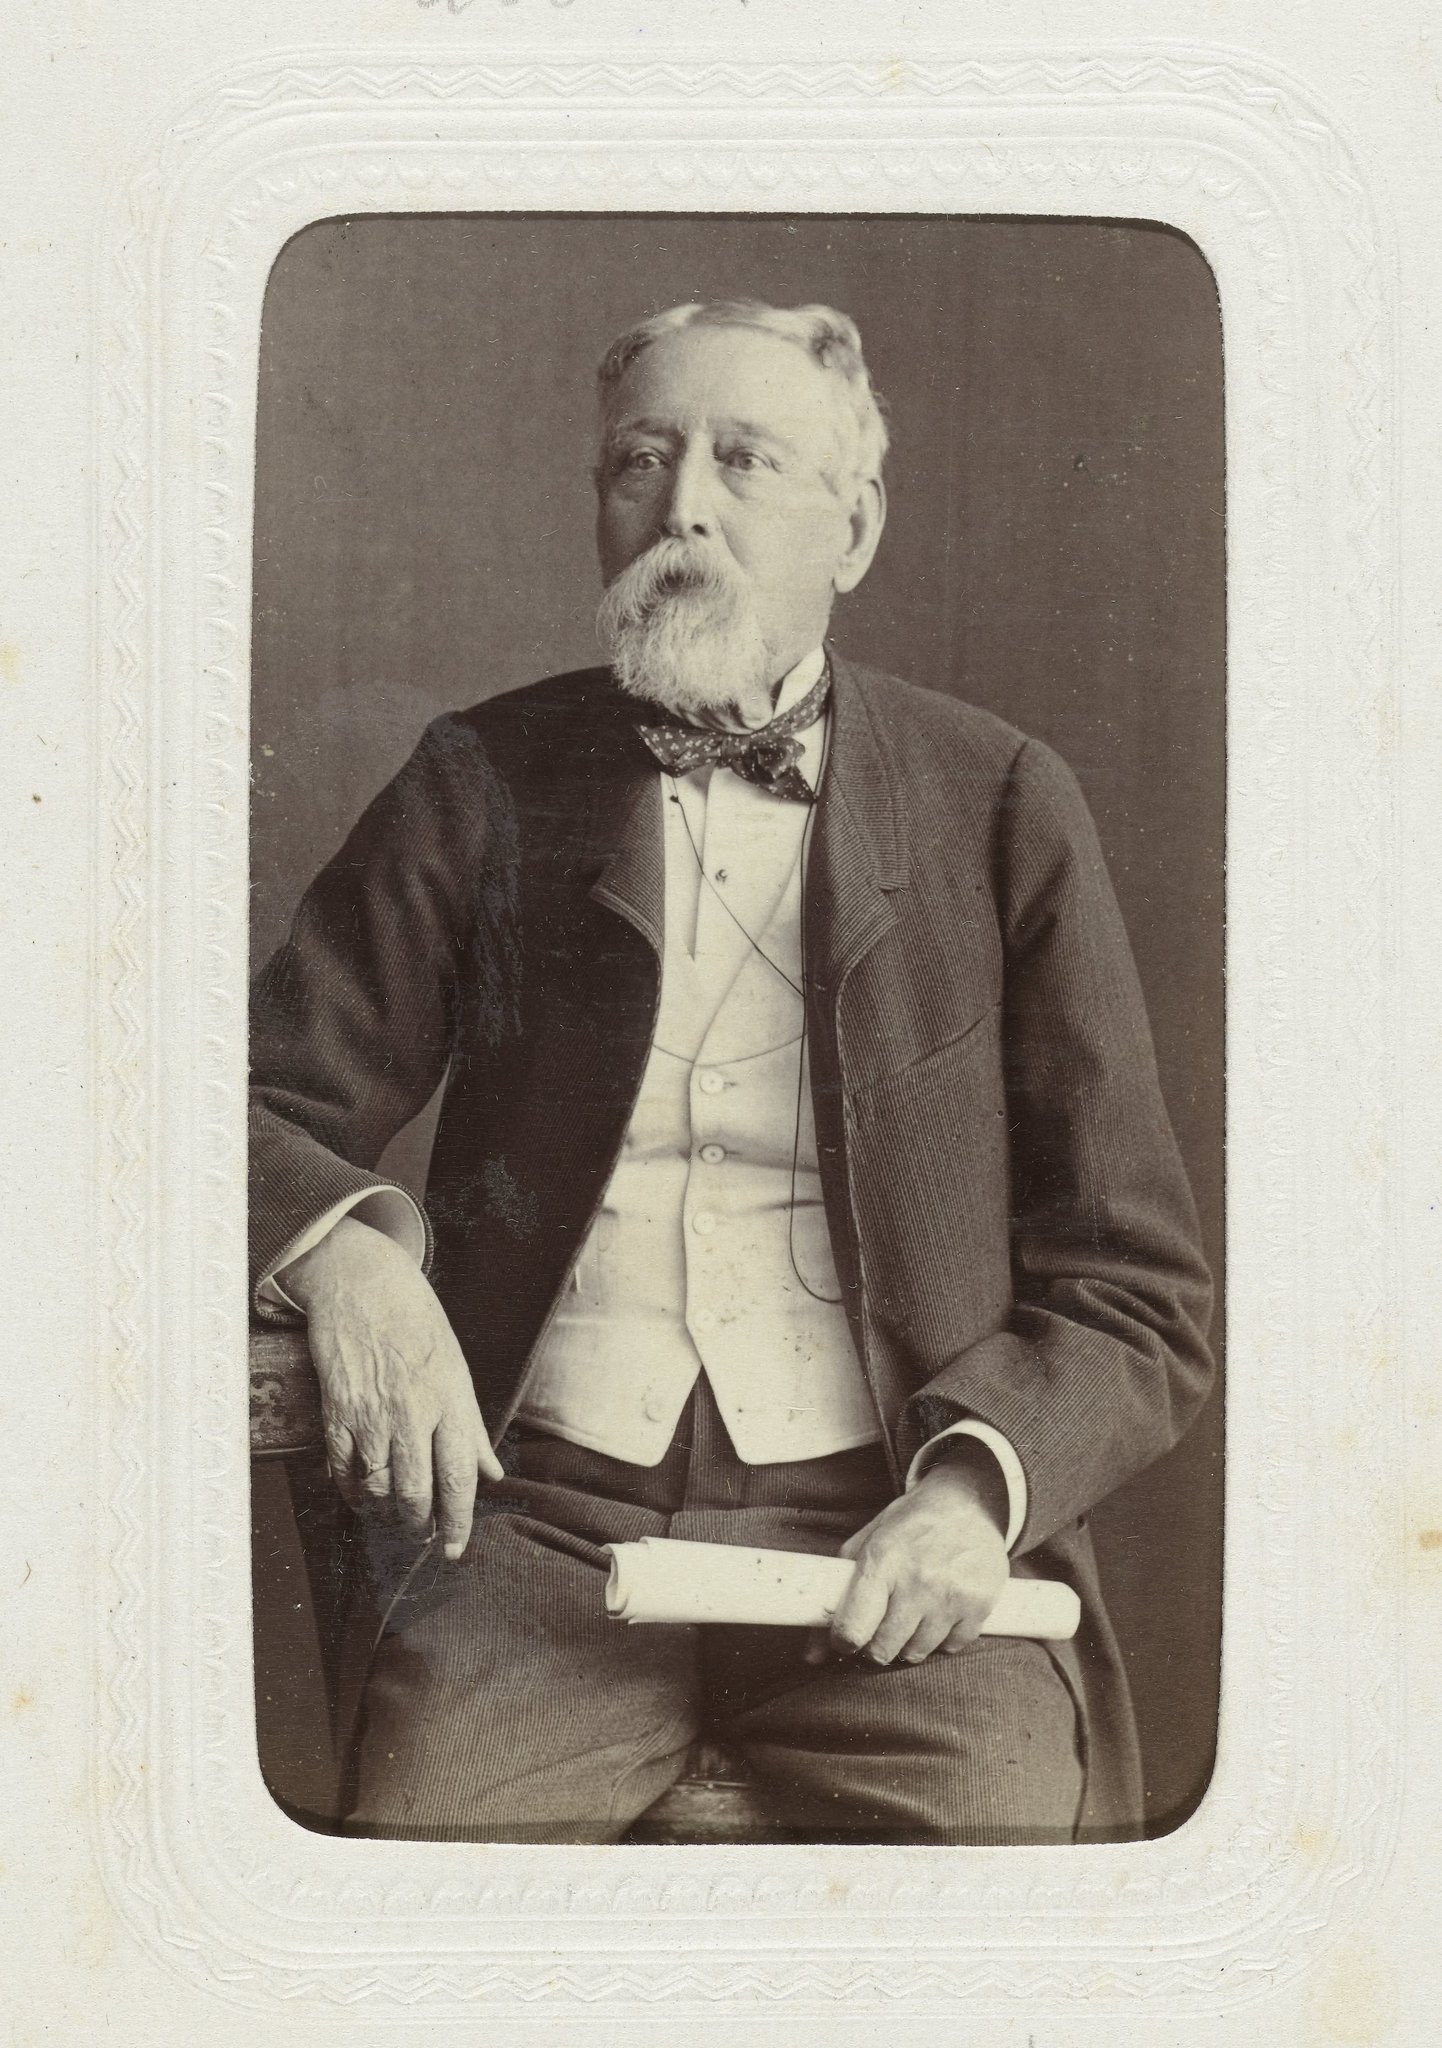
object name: carte de visite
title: Studioportret van een man op leeftijd met baard en snor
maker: Anonymous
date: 1863-1866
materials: cardboard, paper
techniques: albumen print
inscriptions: inscription: ‘founda neur de la societe des anris de l'ordre le 19 Mars 1848. Vi Jules de Sals ador (?)’, stamp: ‘Abdullah freres Constantinopel’